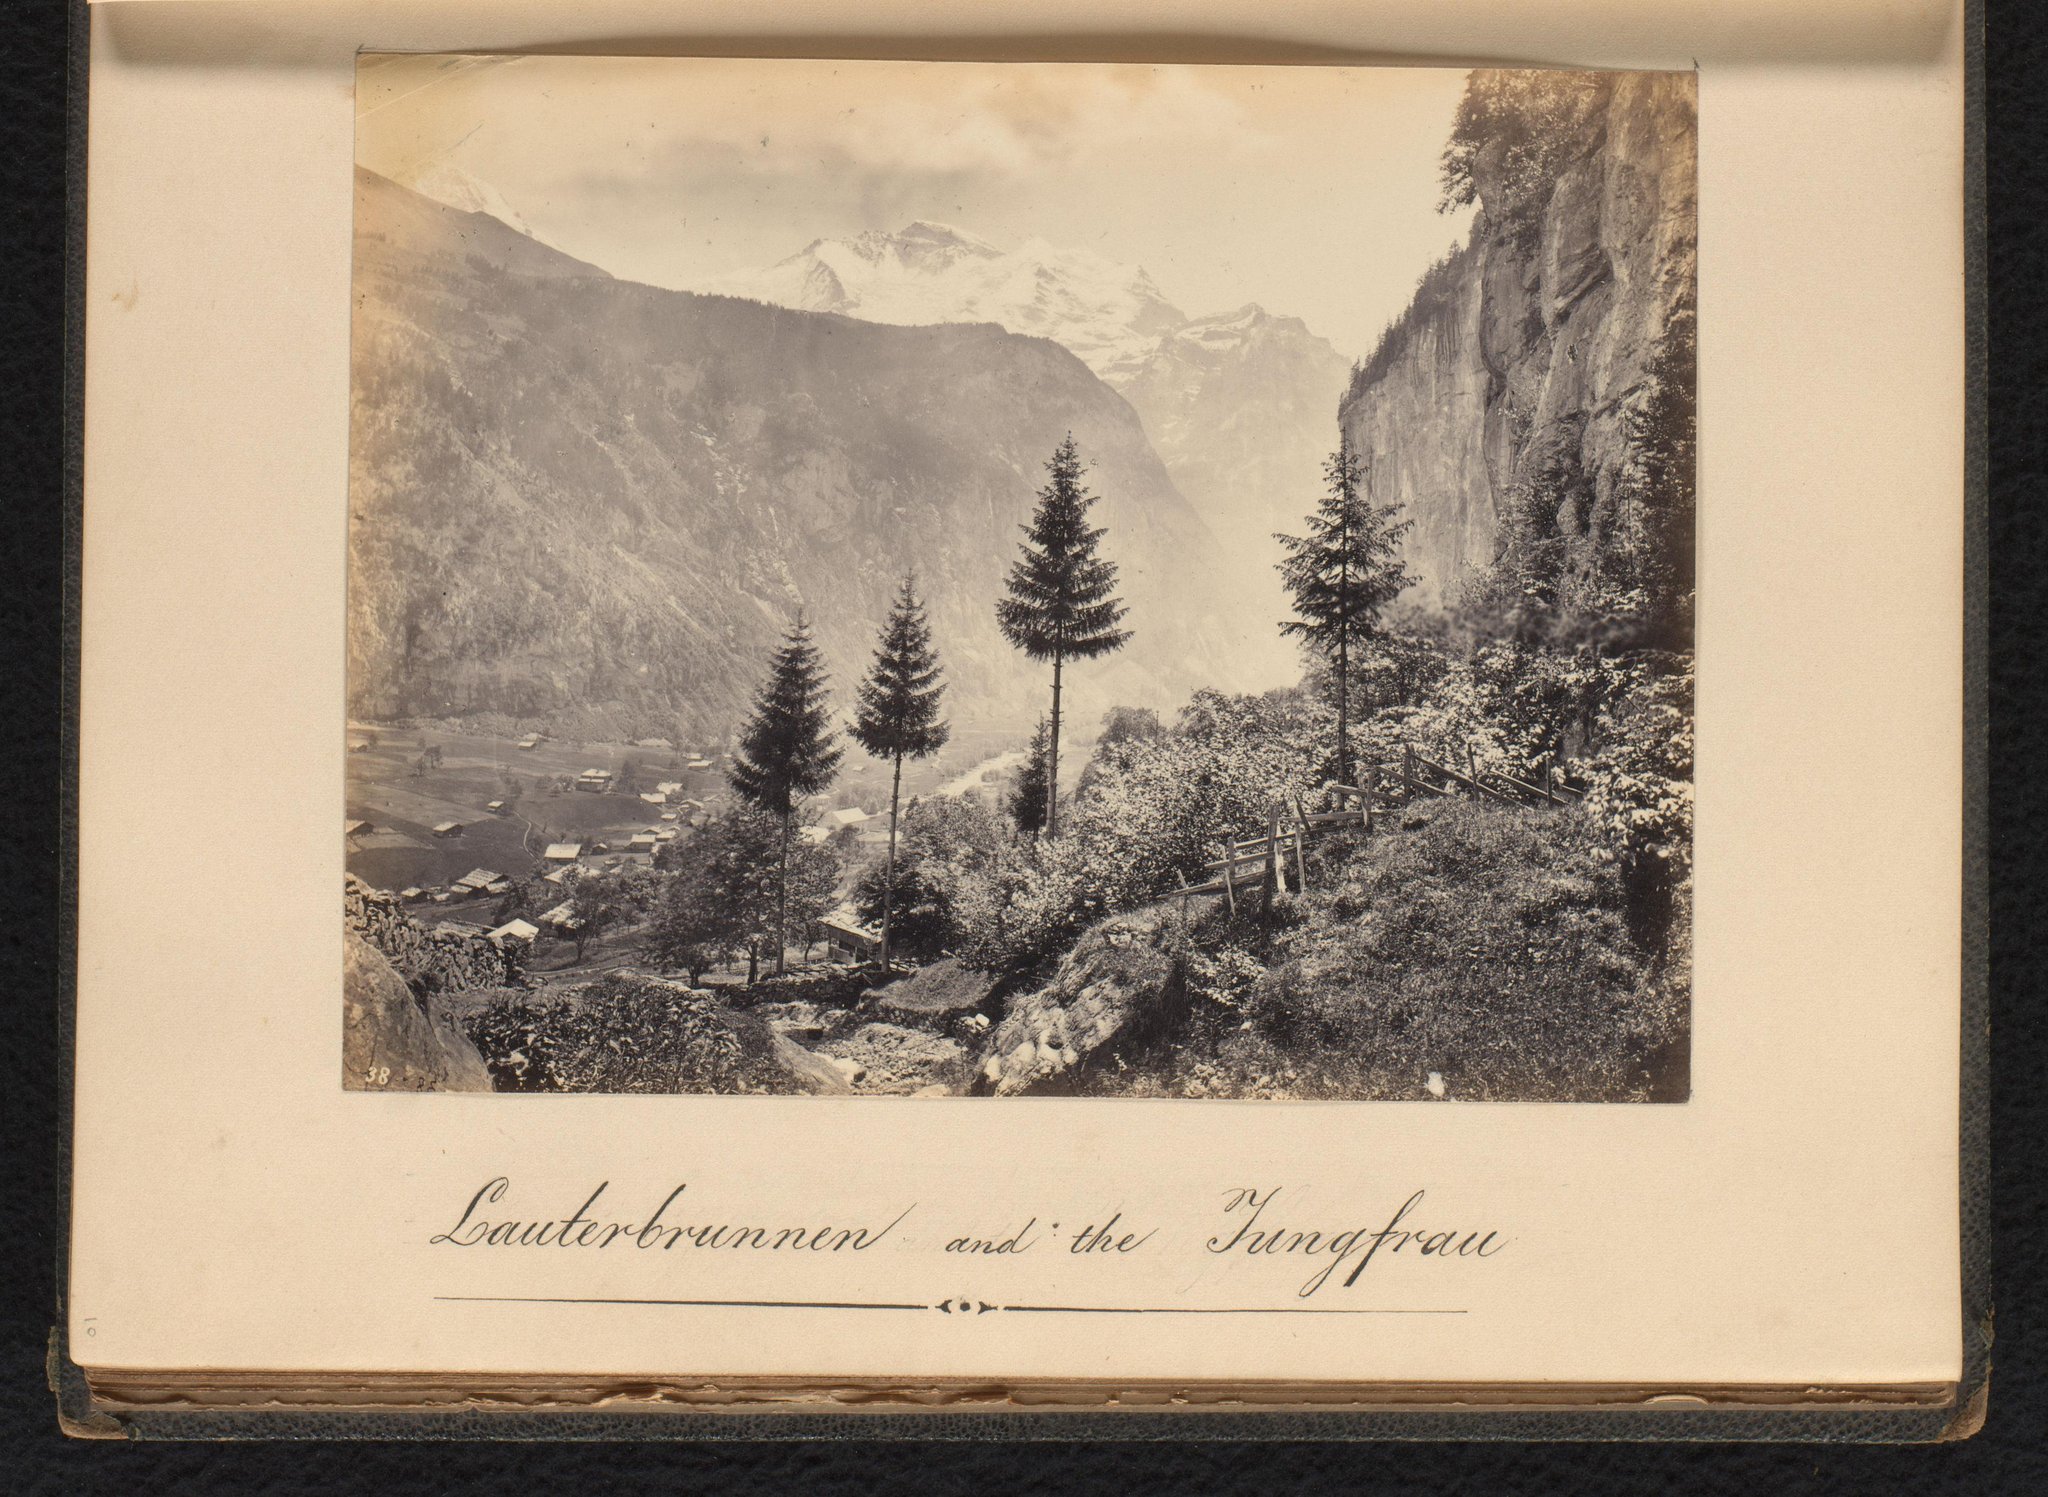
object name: album leaf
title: Lauterbrunnen and the Jungfrau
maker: Anonymous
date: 1860-1870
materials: paper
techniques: albumen print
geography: berner oberland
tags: mountains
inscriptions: number: ‘38’, inscription: ‘38. Lauterbrunnen and the Jungfrau’